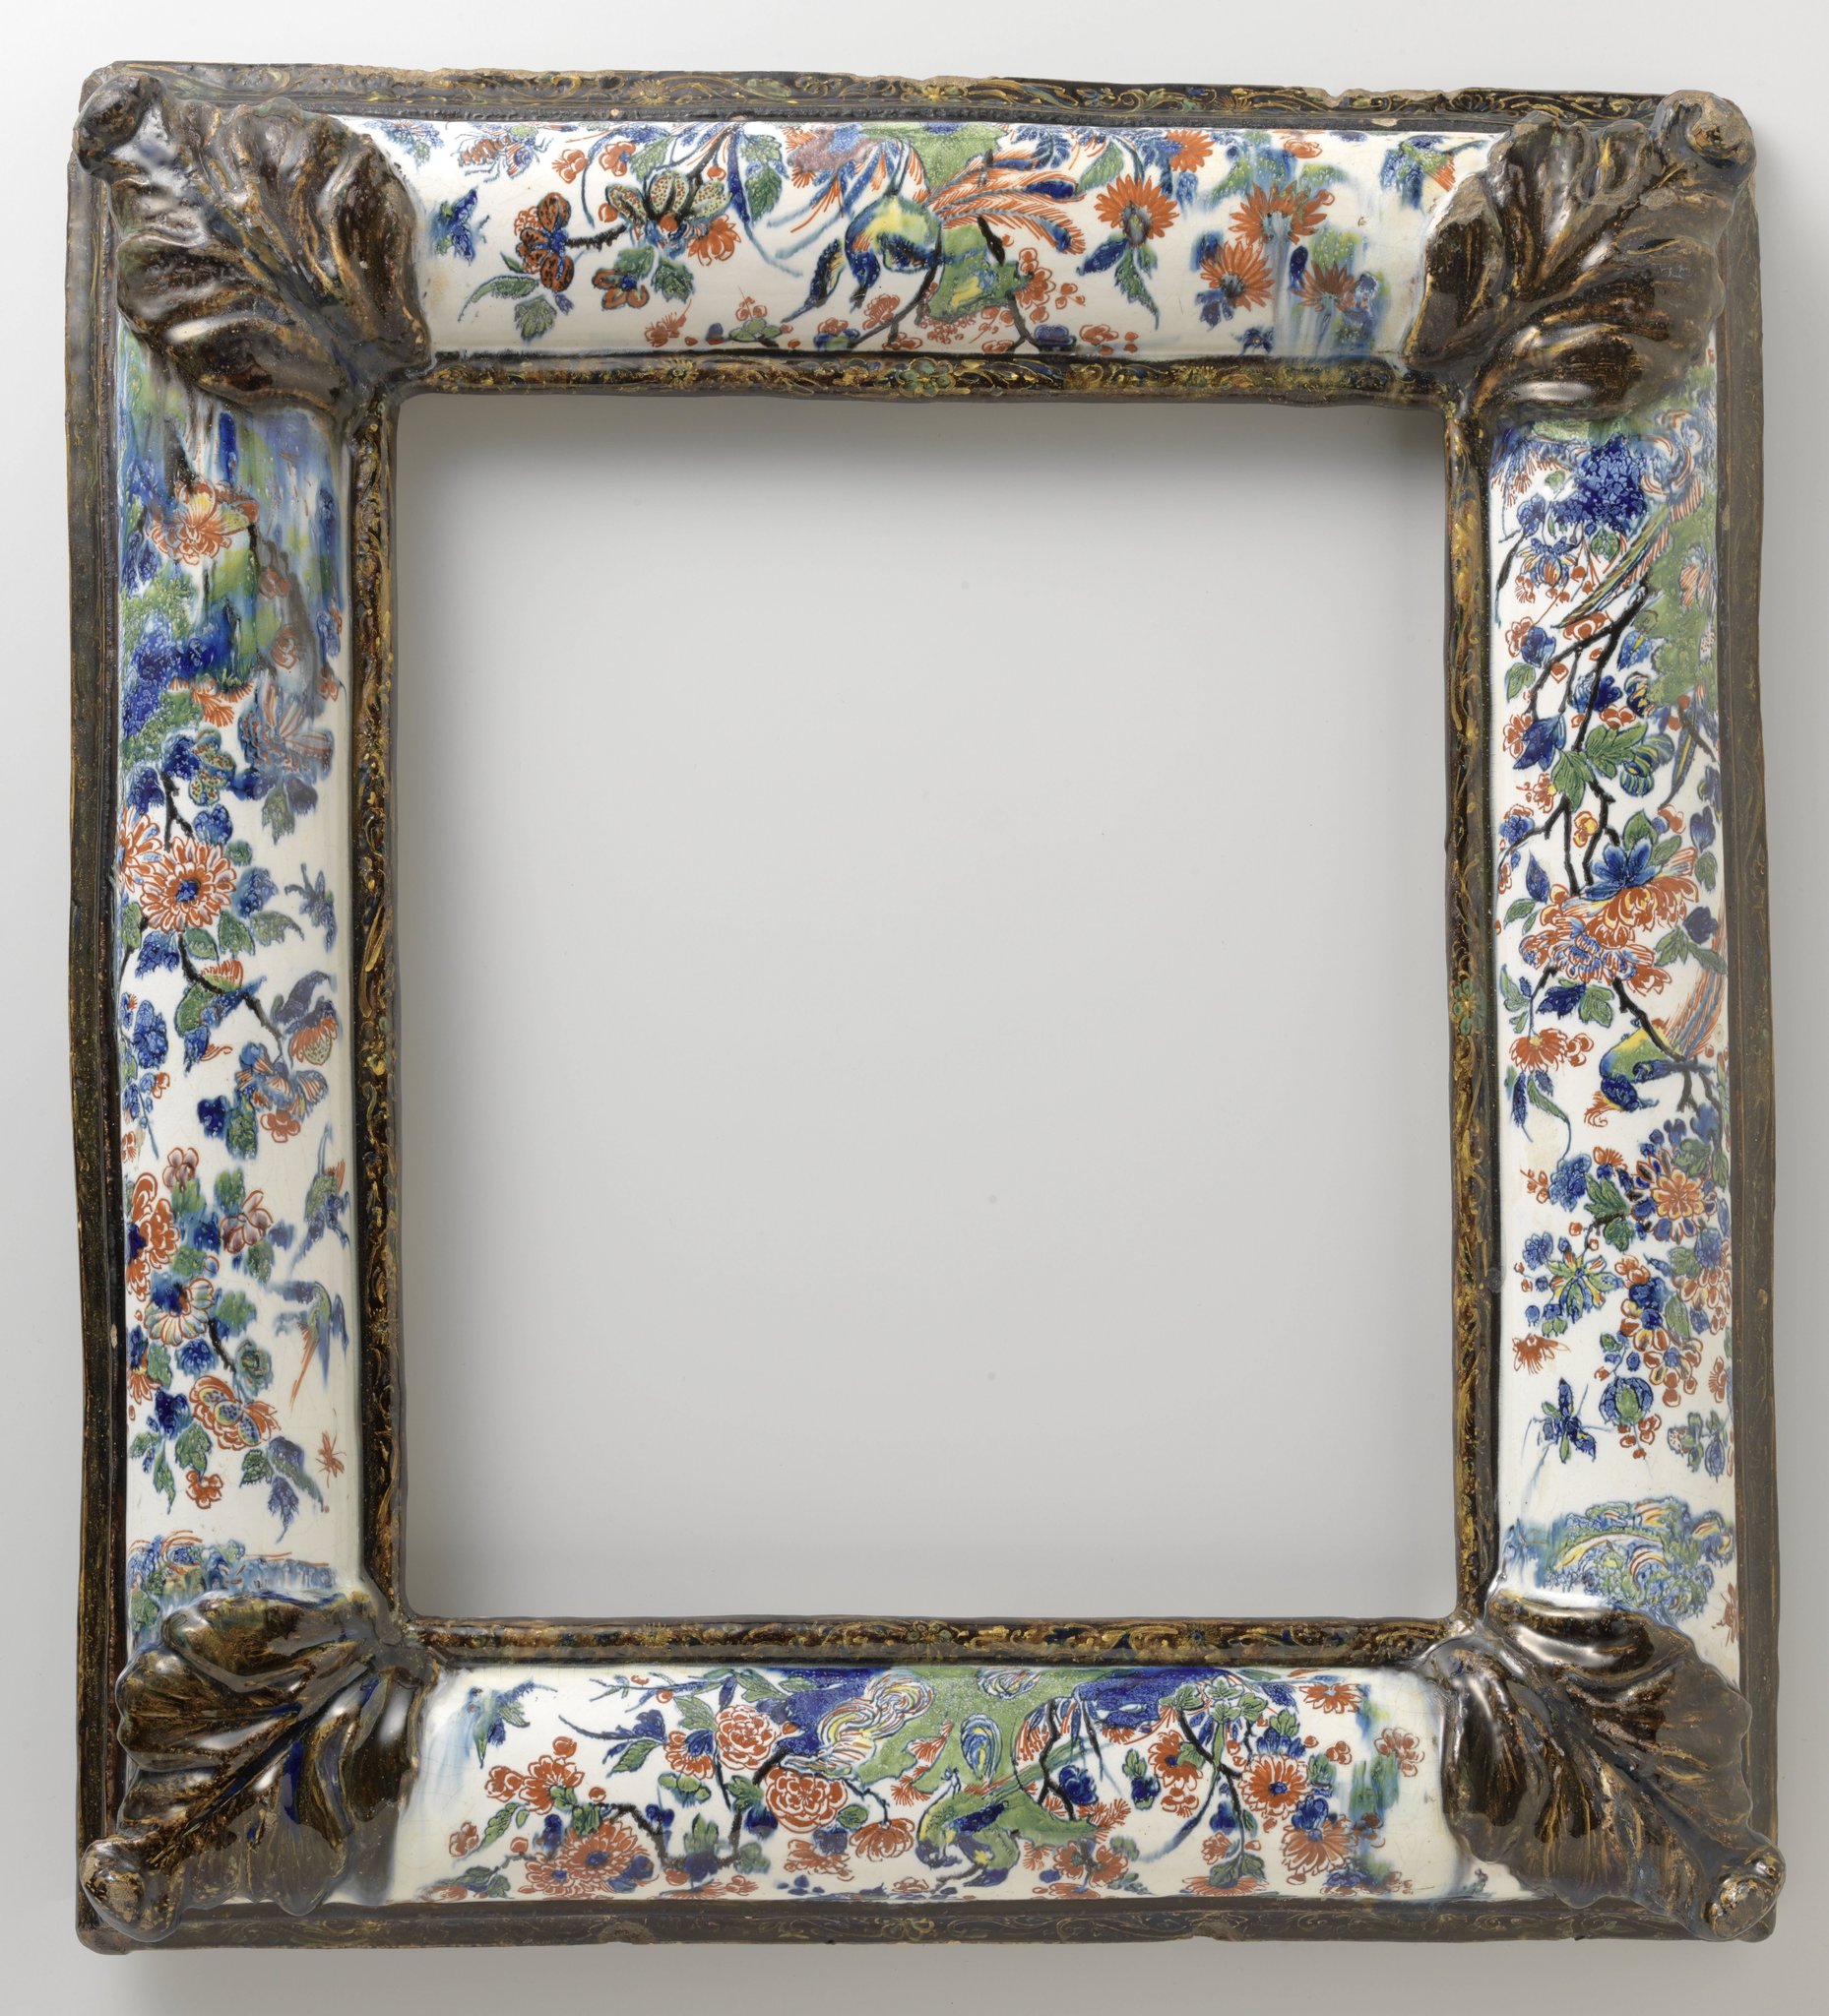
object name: frame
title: Spiegellijst, veelkleurig beschilderd met bloemtakken en vogels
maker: Anonymous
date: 1695-1720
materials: faience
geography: delft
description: Spiegellijst van faience. Veelkleurig beschilderd met bloemtakken en vogels. Op de hoeken acanthusbladeren in relief. Het bolle deel van de lijst is beschilderd in blauw, rood, groen, geel en mangaanpaars met rotsen, waaruit bloeiende planten ontspruiten; vogels op de takken. De randen zijn beschilderd in geel, groen en blauw met ranken op zwartbruine grond. De acanthusbladeren zijn eveneens zwartbruin met groene, blauwe en gele vlekken en strepen. De achterzijde van de lijst is hol en vertoont in het midden tussenschotten.